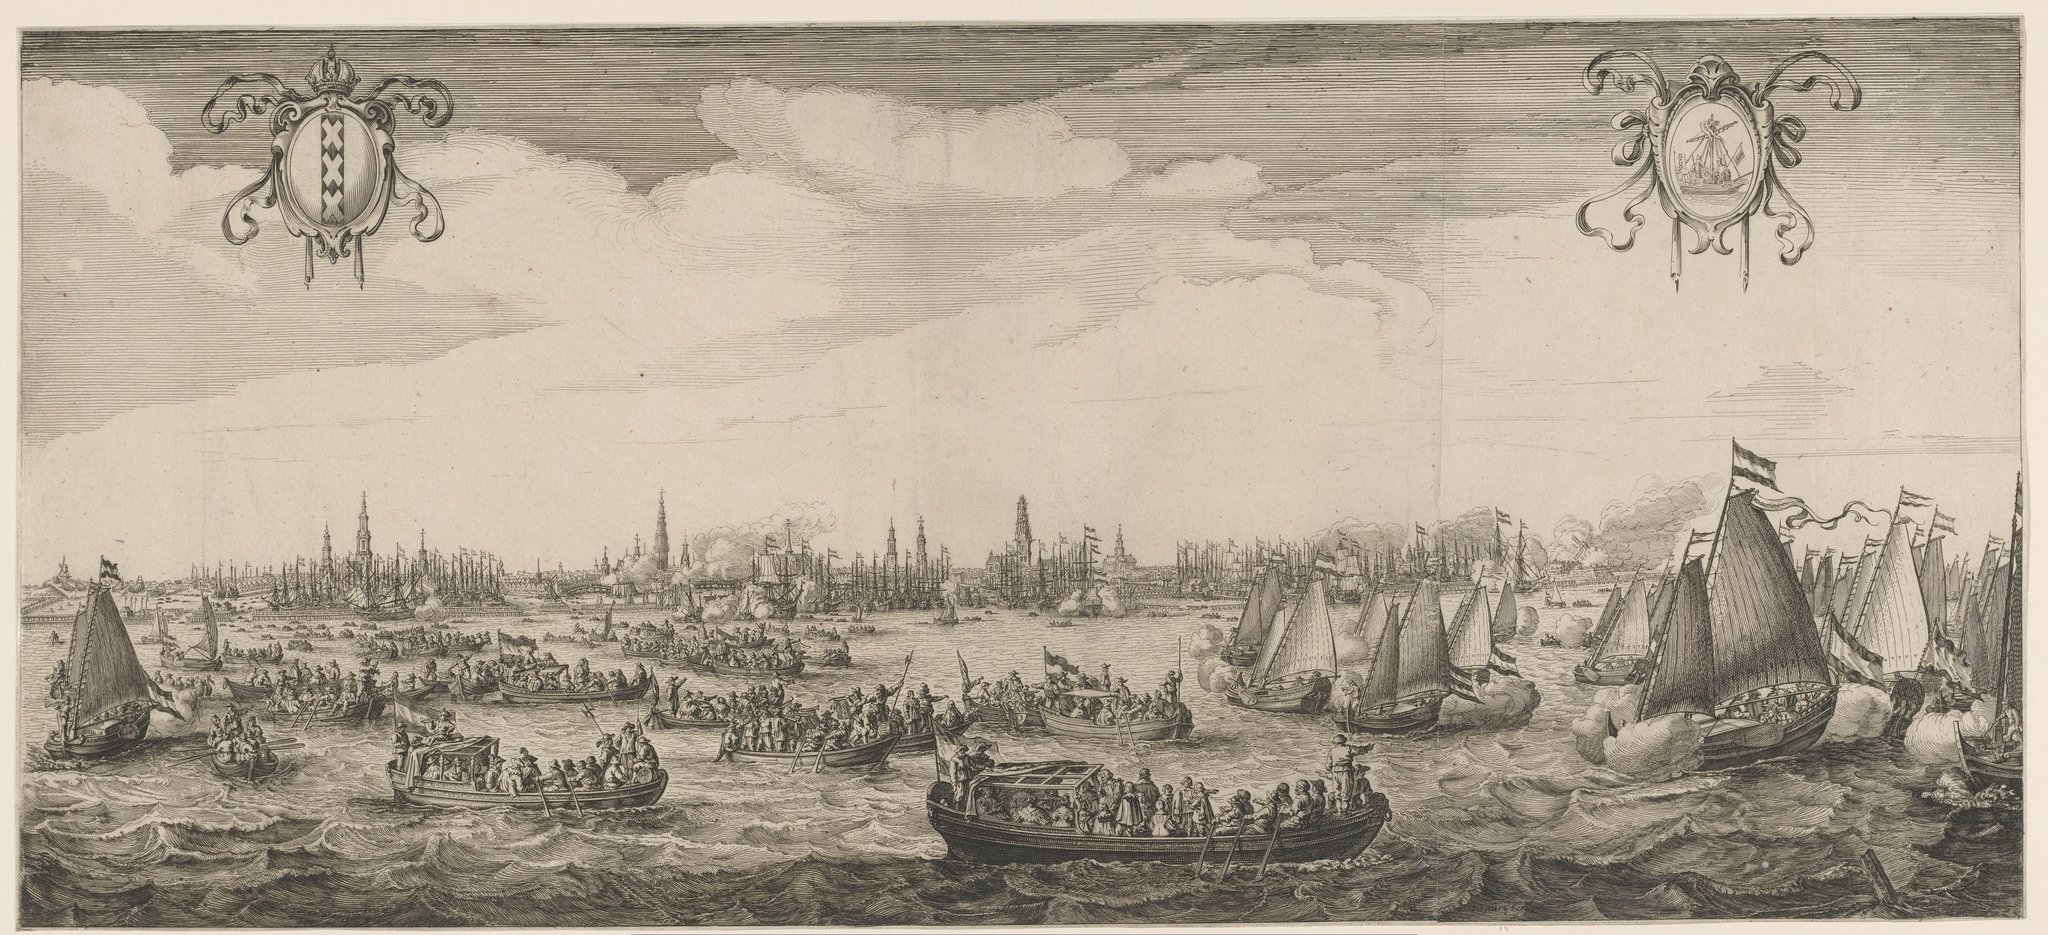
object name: print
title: Feestelijkheden bij het bezoek van Maria de' Medici aan Amsterdam in 1638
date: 1638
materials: paper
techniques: engraving, etching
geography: amsterdam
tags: cologne, print maker, maria de' medici, coat of arms (as symbol of the state, etc.) (+ city; municipal), sailing-ship, sailing-boat, seal (as symbol of the state, etc.) (+ city; municipal), triumphal entry and public reception, pageant, 'entrée solennelle', 'joyeuse entrée', rowing-boat, canoe, etc., prospect of city, town panorama, silhouette of city, amsterdam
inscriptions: collector's mark: Lugt 195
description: Prent ook gebruikt in:* Baerle, Caspar van. Medicea hospes, sive descriptio publicae gratulationis, qua Serenissimam, Augustissimamque Reginam, Mariam de Medicis (…). Amsterdam: Johannes en Cornelis Willemsz. Blaeu, 1638. En in: Baerle, Caspar van. Marie de Medicis, entrant dans Amsterdam : ou, histoire de la reception faicte à la Reyne Mere du Roy tres-Chrestien (…). Amsterdam: Johannes en Cornelis Willemsz. Blaeu, 1638. En in: Baerle, Caspar van en Joost van den Vondel. Blyde inkomst der allerdoorluchtighste koninginne, Maria de Medicis t' Amsterdam. Vertaelt uit het Latijn (…). Amsterdam: Johannes en Cornelis Willemsz. Blaeu, 1639. * Doorgaans zijn de prenten in de bovengenoemde publicaties rechtsonder genummerd (van de huidige prent is dat de derde bekende staat). Maar er zijn ook exemplaren waarin eerdere, ongenummerde, staten van de prenten (van de huidige prent de eerste en tweede bekende staat) zijn ingebonden.